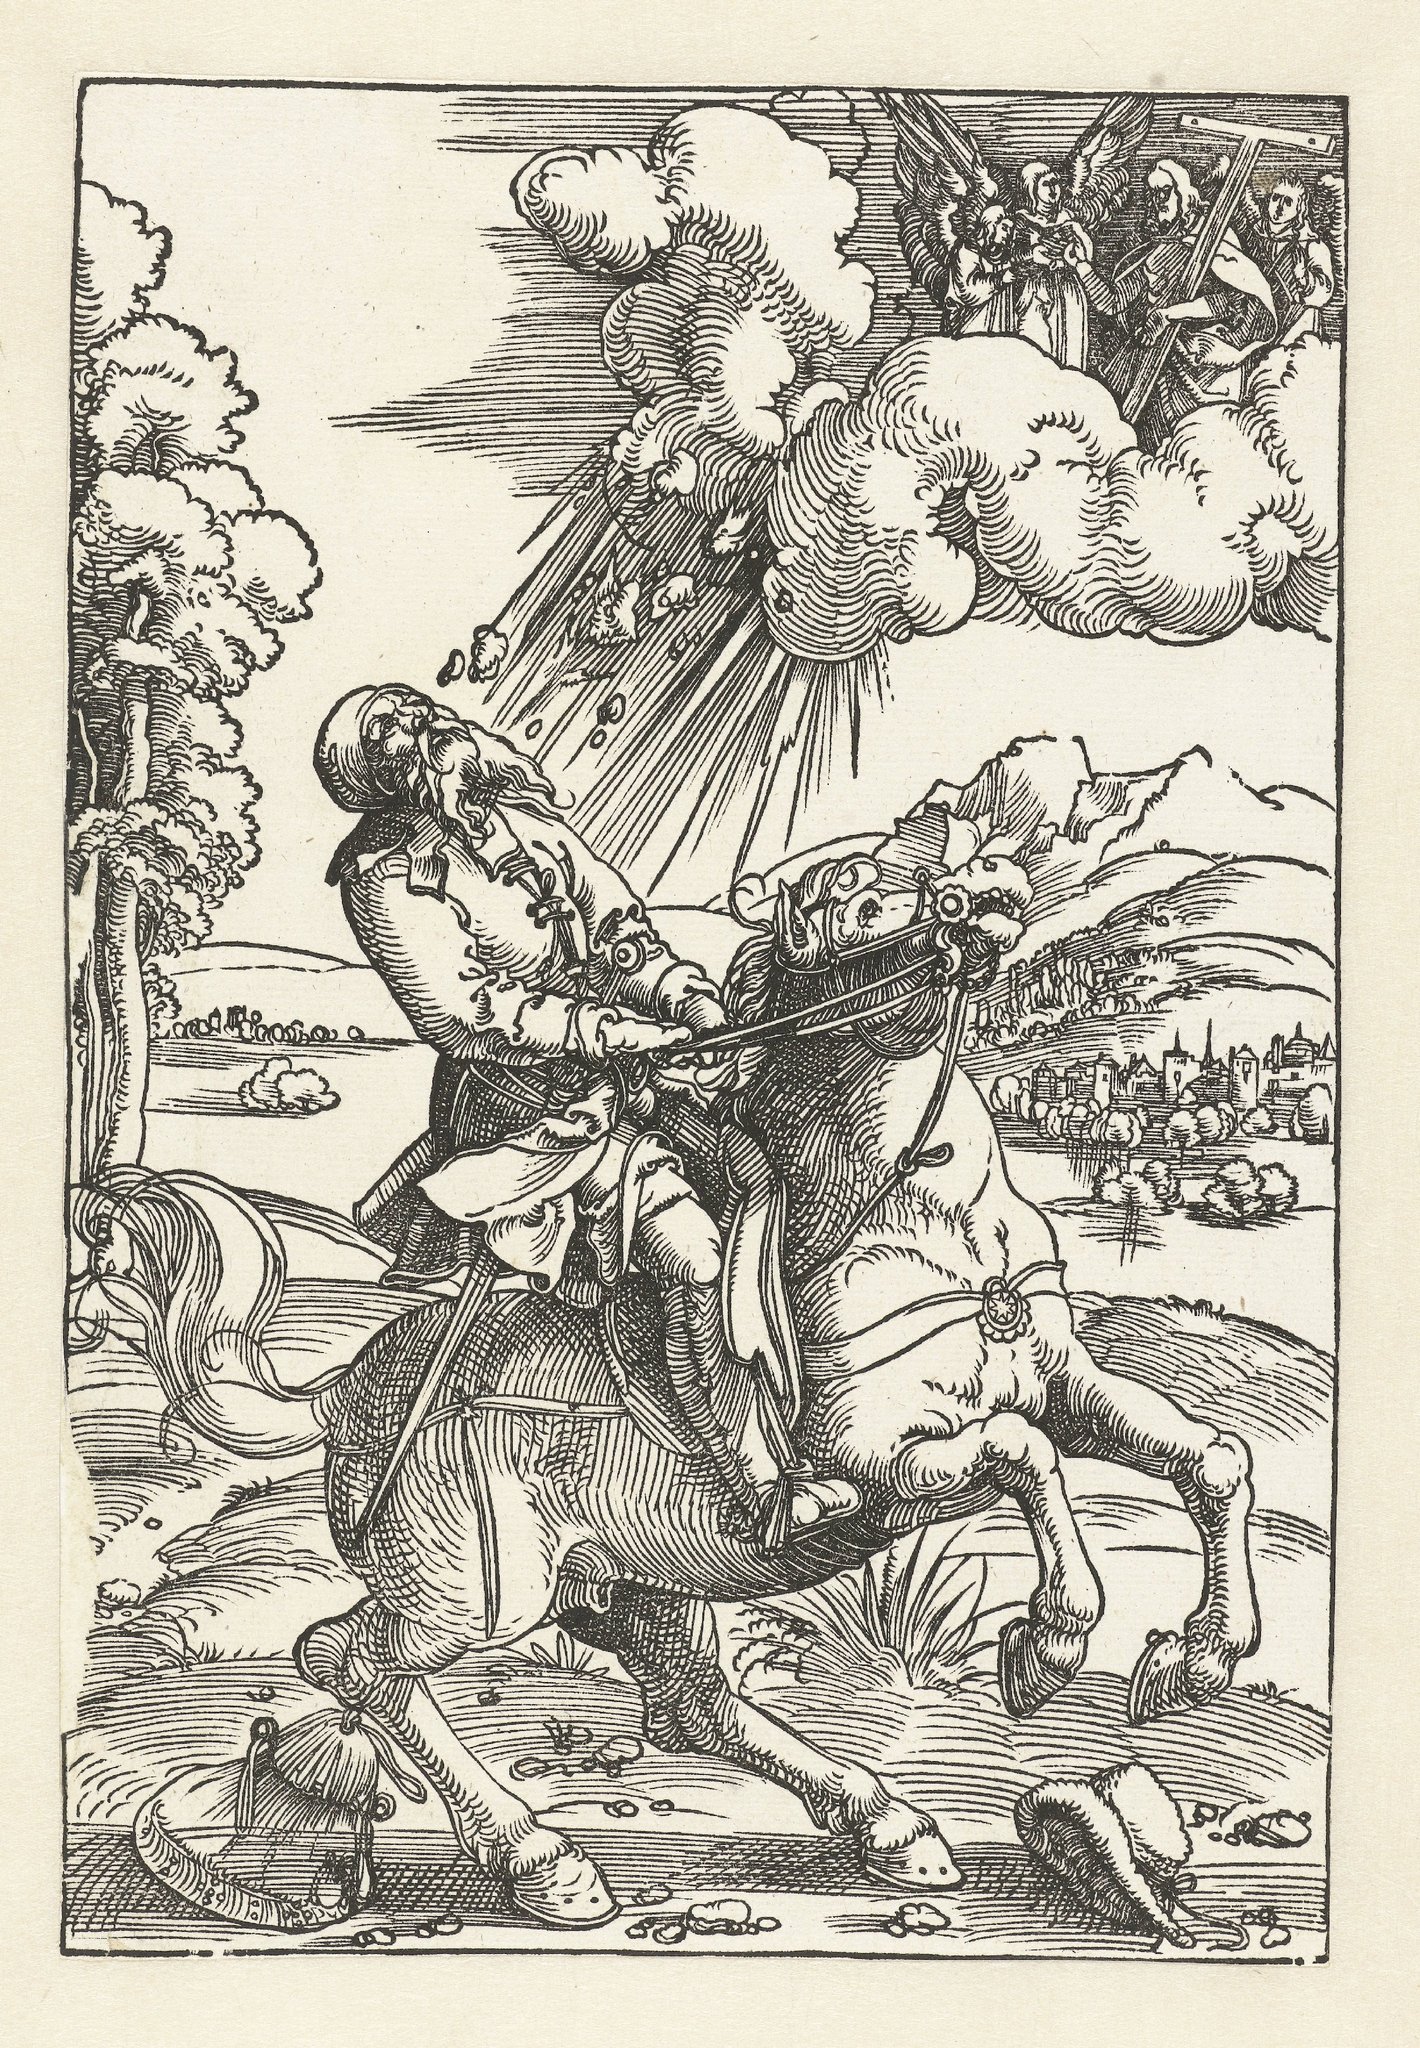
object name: print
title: Bekering van Paulus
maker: hans baldung grien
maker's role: draughtsman, print maker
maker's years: 1484-1545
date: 1505-1507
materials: paper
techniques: woodcut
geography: nuremberg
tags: on the way to damascus christ appears to saul, who falls from his horse and is blinded by the light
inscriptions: collector's mark: Lugt 240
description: Paulus is te paard op weg naar Damascus als hij wordt verblind door licht uit de hemel. Zijn paard steigert en zijn hoed en tas vallen op de grond. Op een wolk verschijnt Christus met een Taukruis en drie engelen.